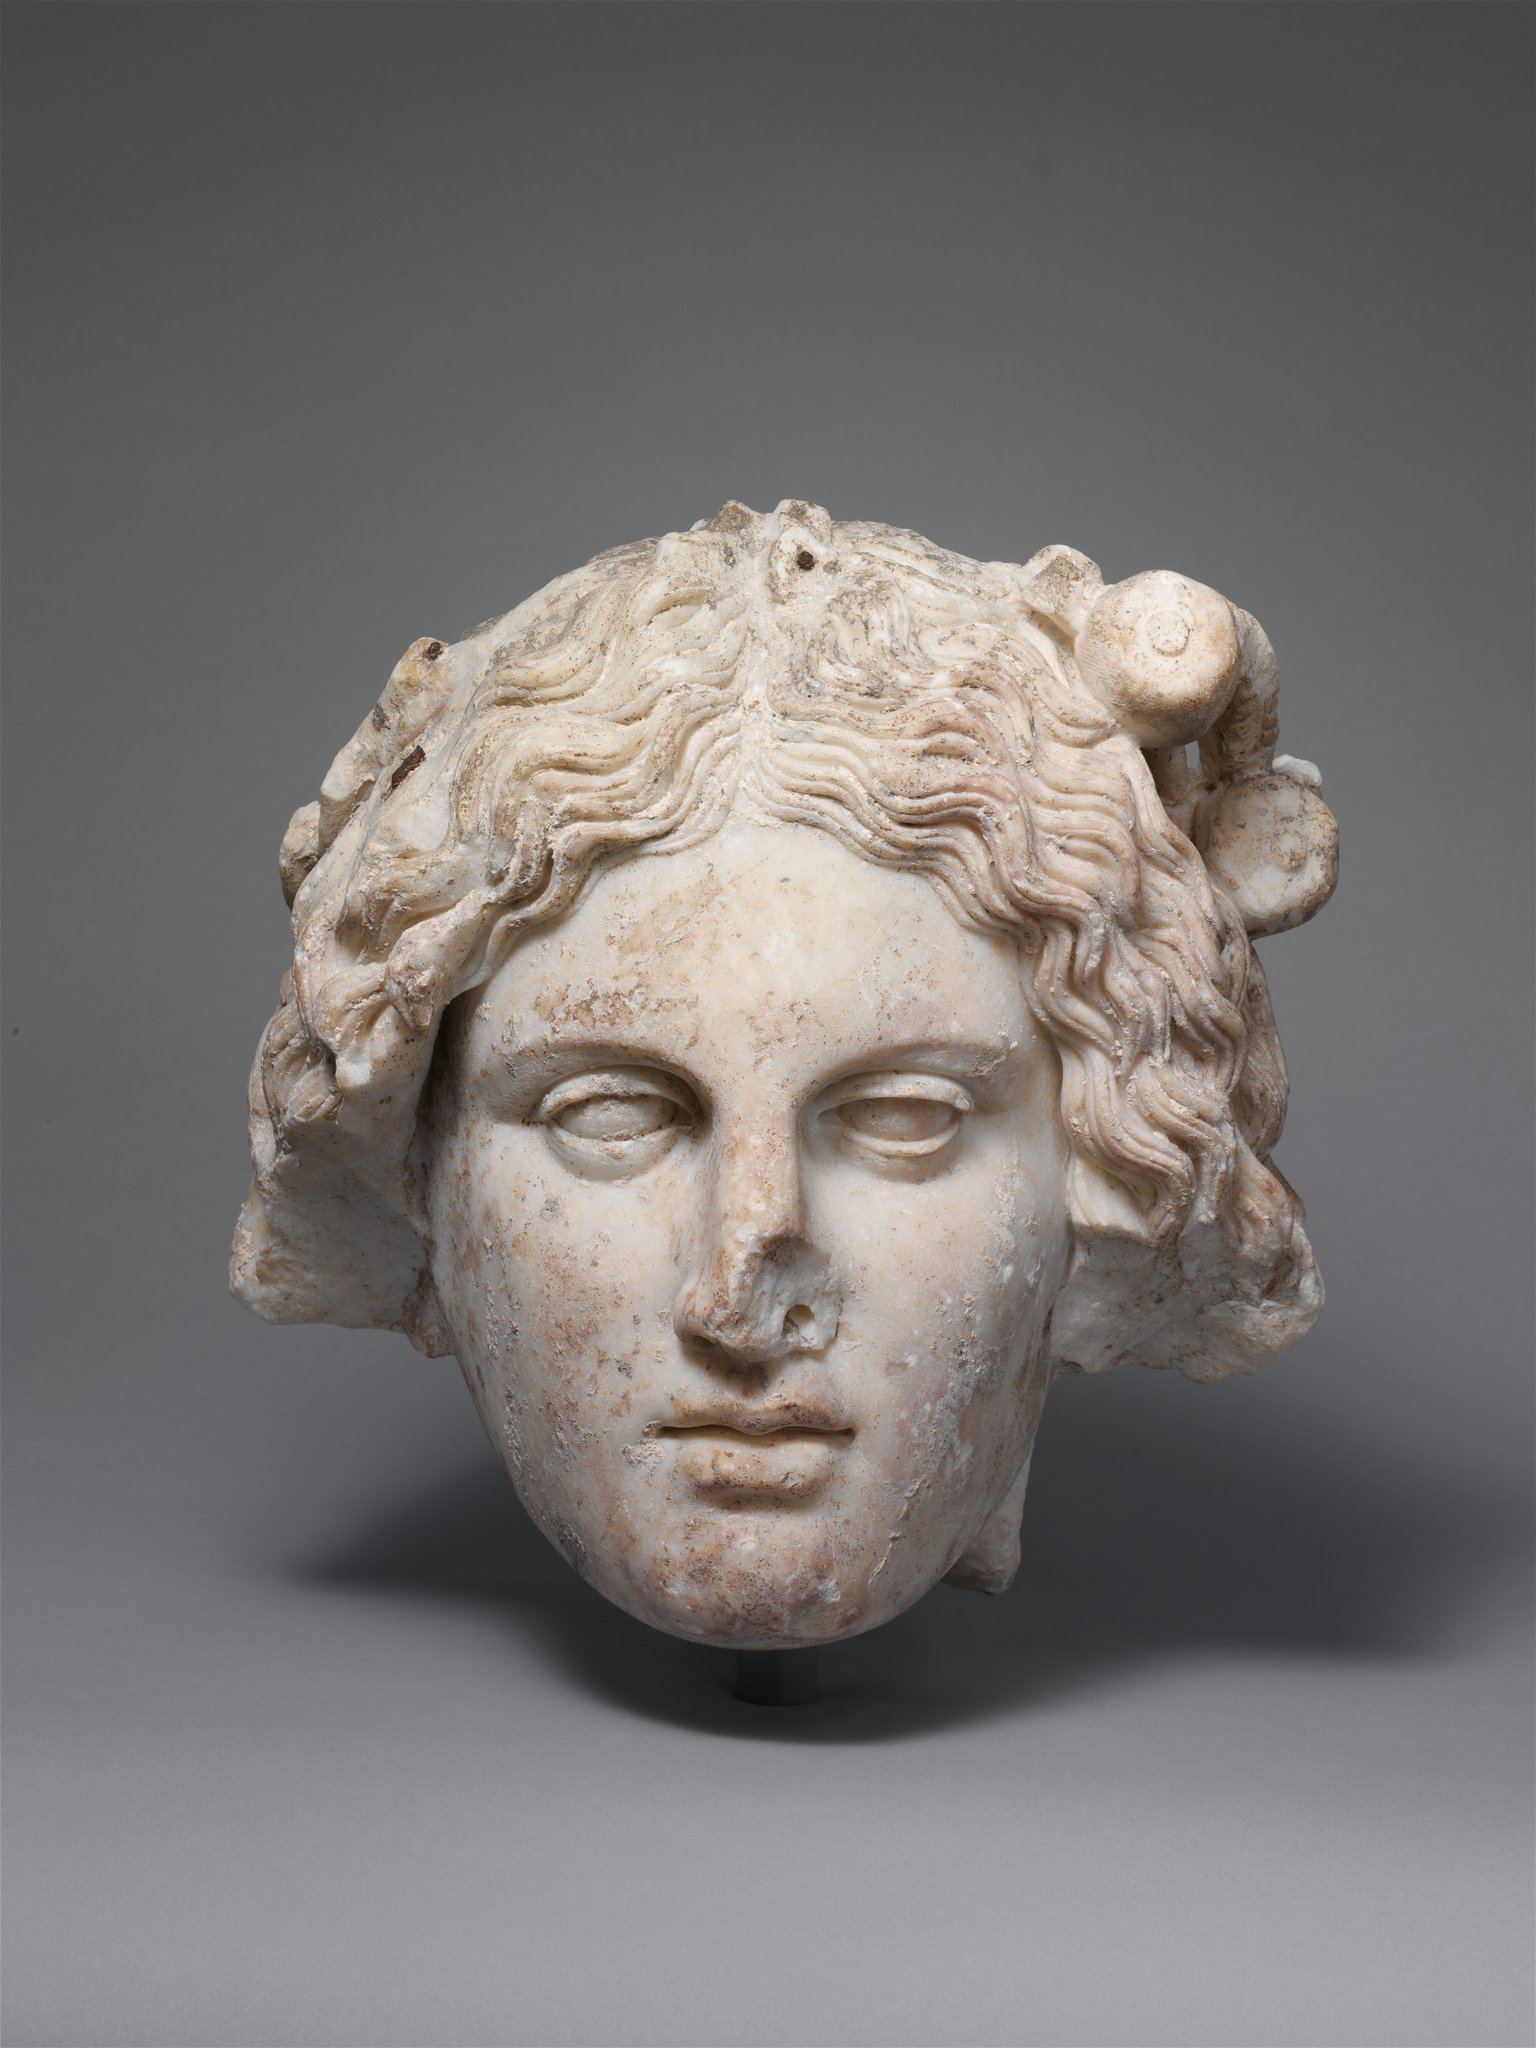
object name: head of cere or demeter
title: Marble head of a deity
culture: roman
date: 101-150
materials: marble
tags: pomegranates,heads,ceres,wreaths